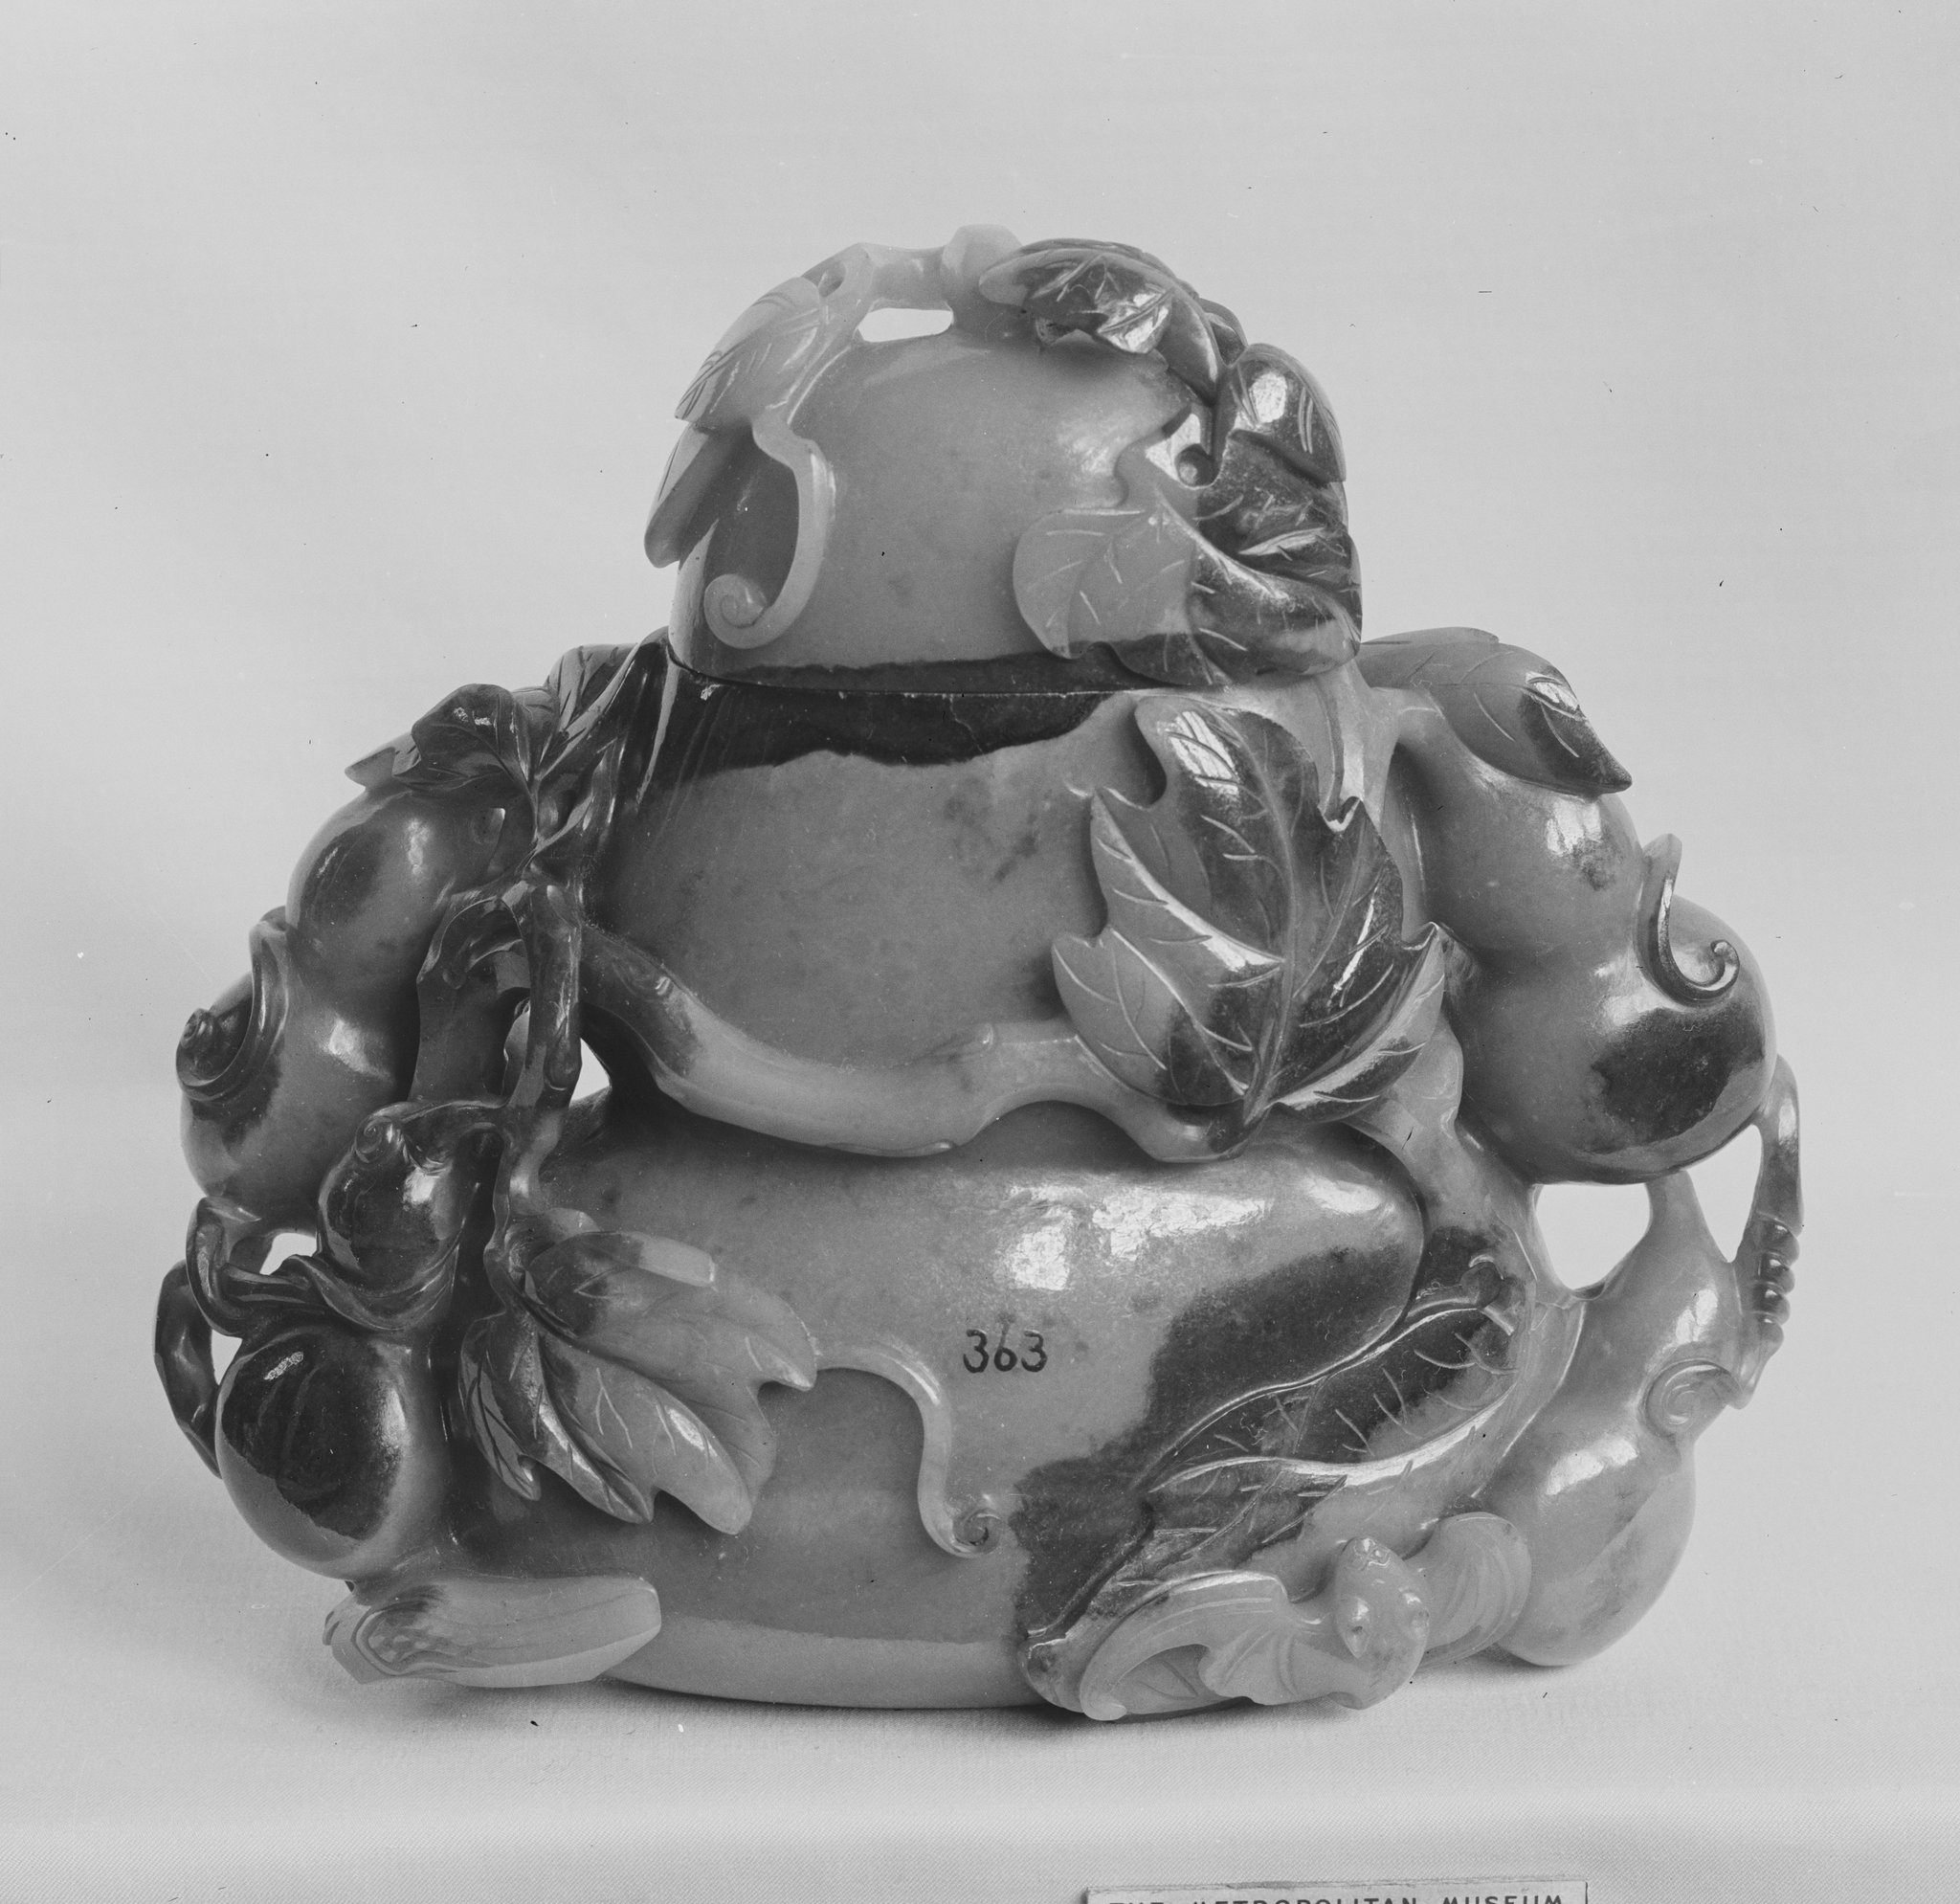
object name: vase with cover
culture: chinese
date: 1368-1644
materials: jade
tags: leaves